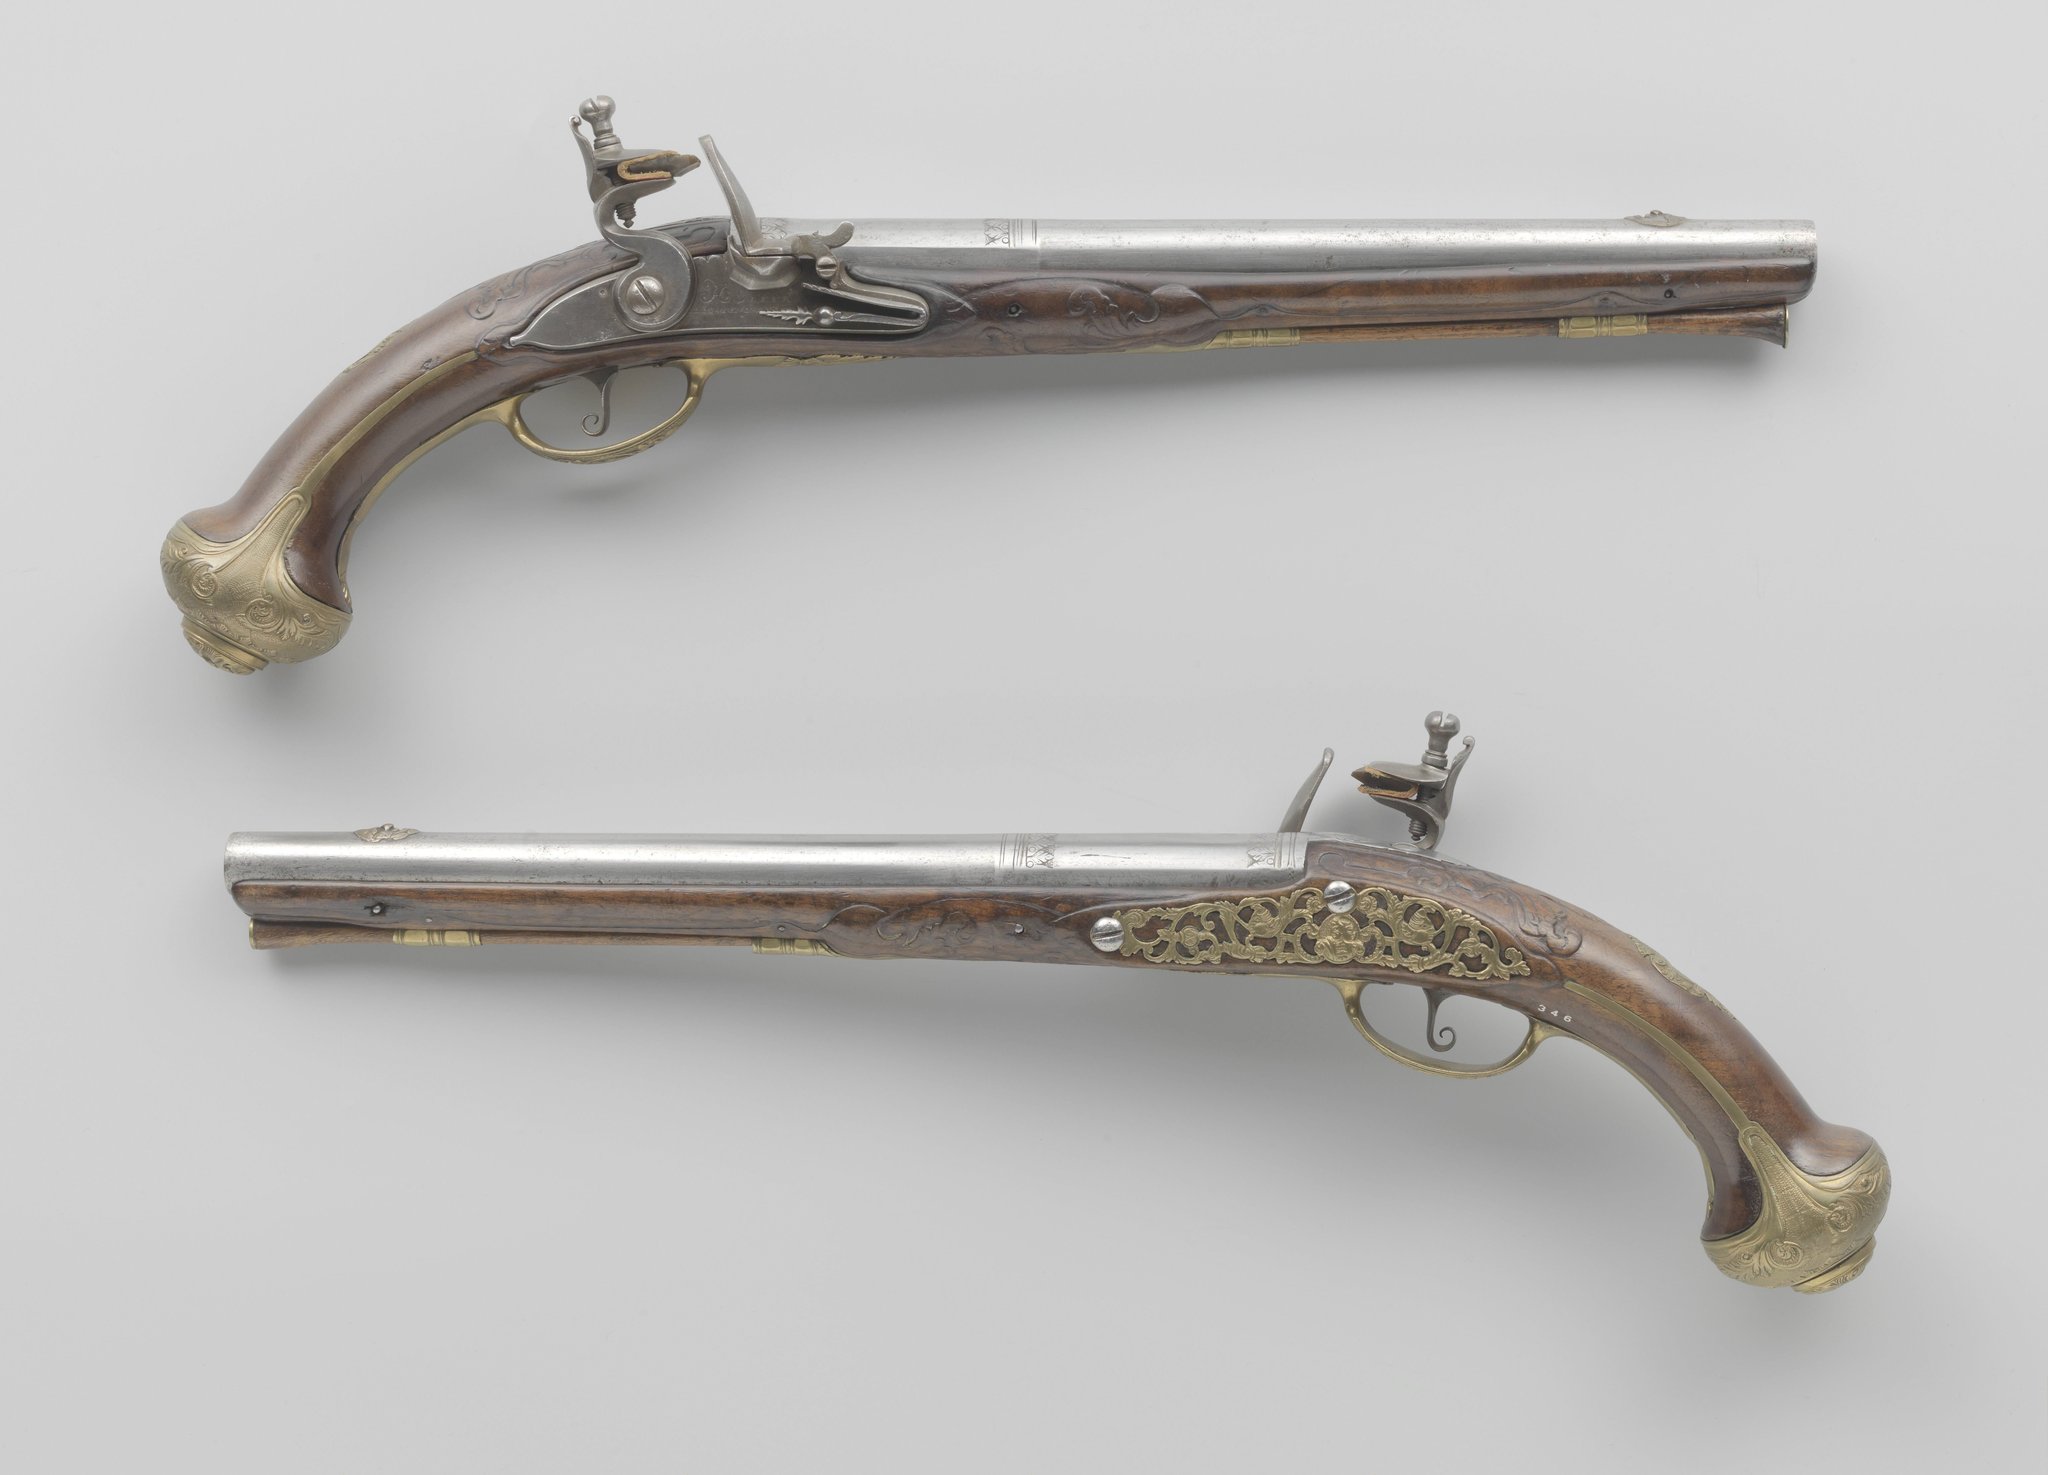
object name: flintlock pistol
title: Vuursteenpistool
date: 1740-1750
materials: brass, stone, iron, silver, wood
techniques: printing, metalworking, cutting, embroidery, engraving, gilding, granulation, relief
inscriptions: signature: ‘H.SLEUR // AMSTERDAM’, mark: ‘IN’, coat of arms